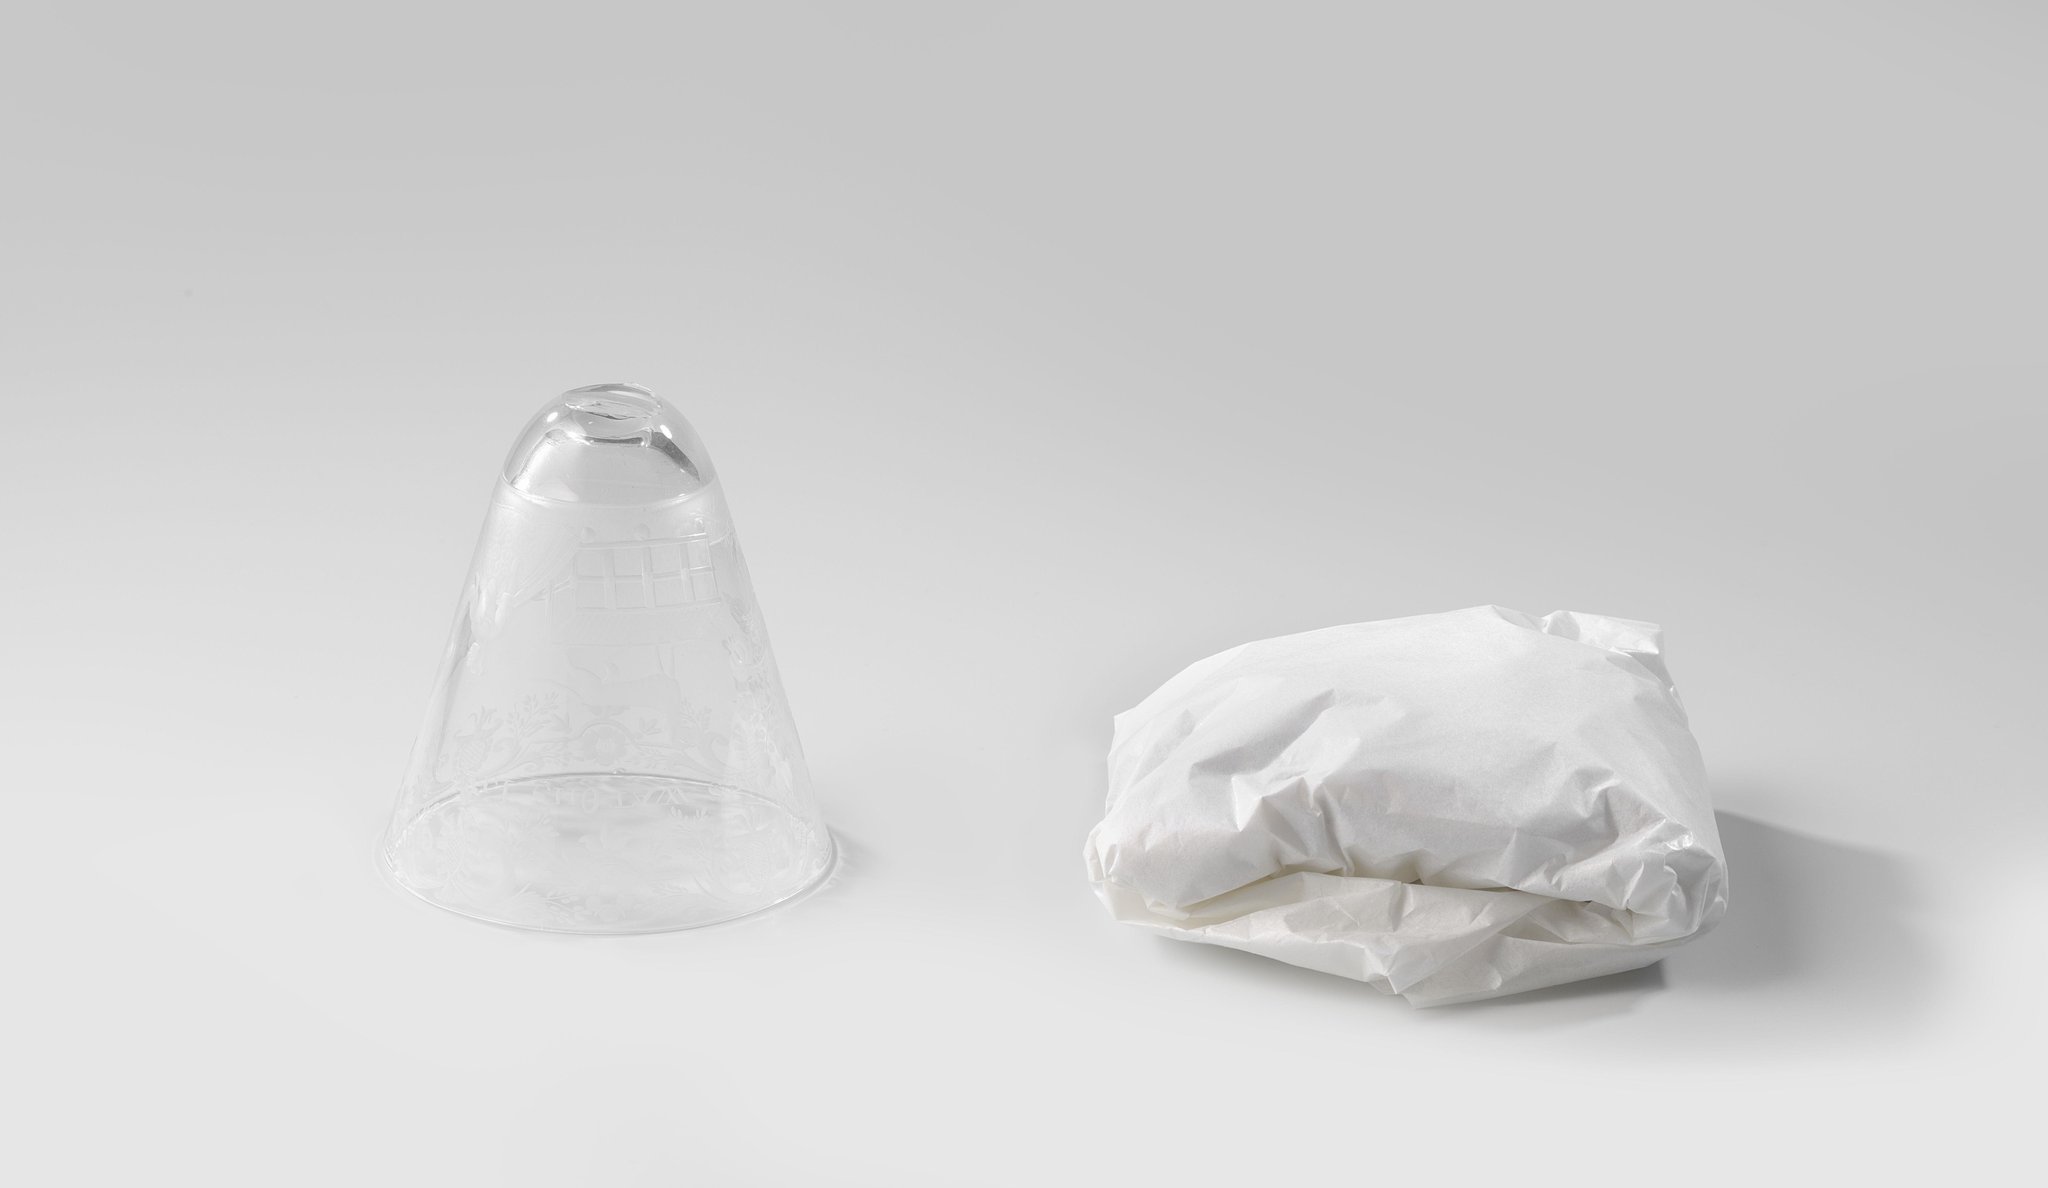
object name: fragment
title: Kelkglas, versierd met radgravures, onder andere een moederfiguur met twee kinderen en de spreuk: ALS WAT ONS LIEF IS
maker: Anonymous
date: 1725-1750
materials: glass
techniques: rotary engraving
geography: england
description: Oorspronkelijk platte voet en balustervormige stam. Conische kelk, aan de onderzijde gebogen. Radgravure voorstellende een moeder met aan de hand twee kinderen, een jongen en een meisje. Links van haar een geldkist met erop een waakhond. Rechts een pony. Naast de pony een vaas met bloemen. Boven de voorstelling de spreuk: ALS WAT ONS LIEF IS. De bovenrand van de kelk is afgezet met een brede ornamentrand. Het Engelse glas is in Nederland gegraveerd.